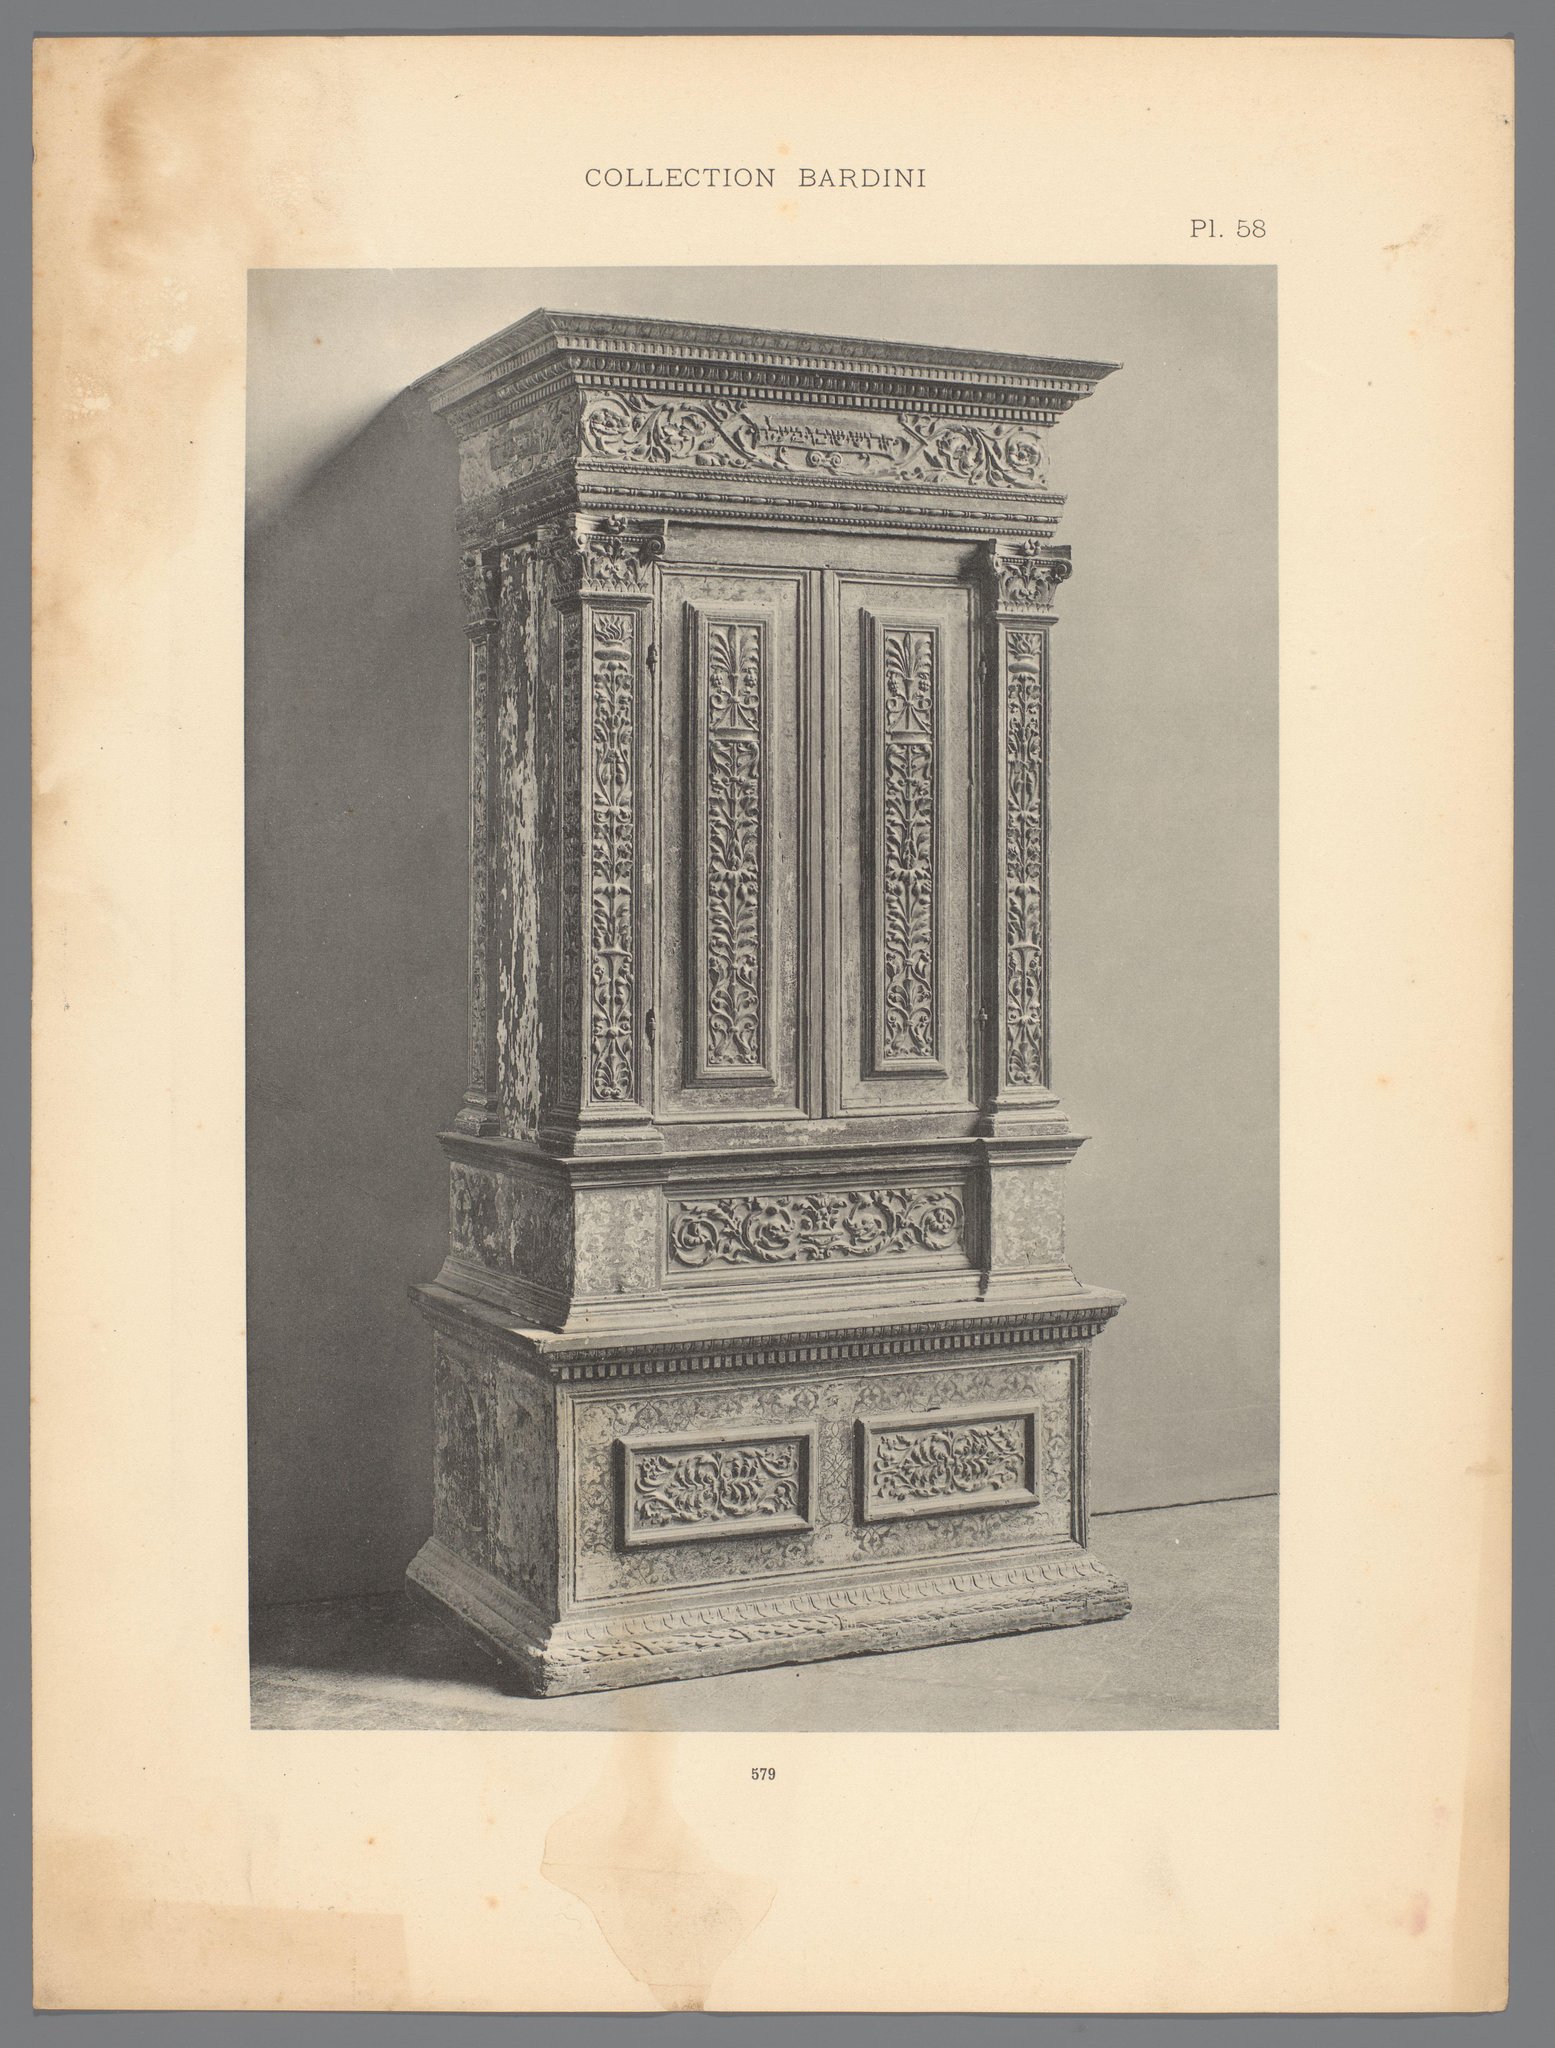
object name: photomechanical print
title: Gedecoreerd kabinet met naar architectuur verwijzende elementen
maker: Anonymous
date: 1875-1930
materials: paper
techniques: photograph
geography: florence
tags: ornamental cupboard (+ wood and other phytogenic material)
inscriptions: number: ‘Pl. 58’